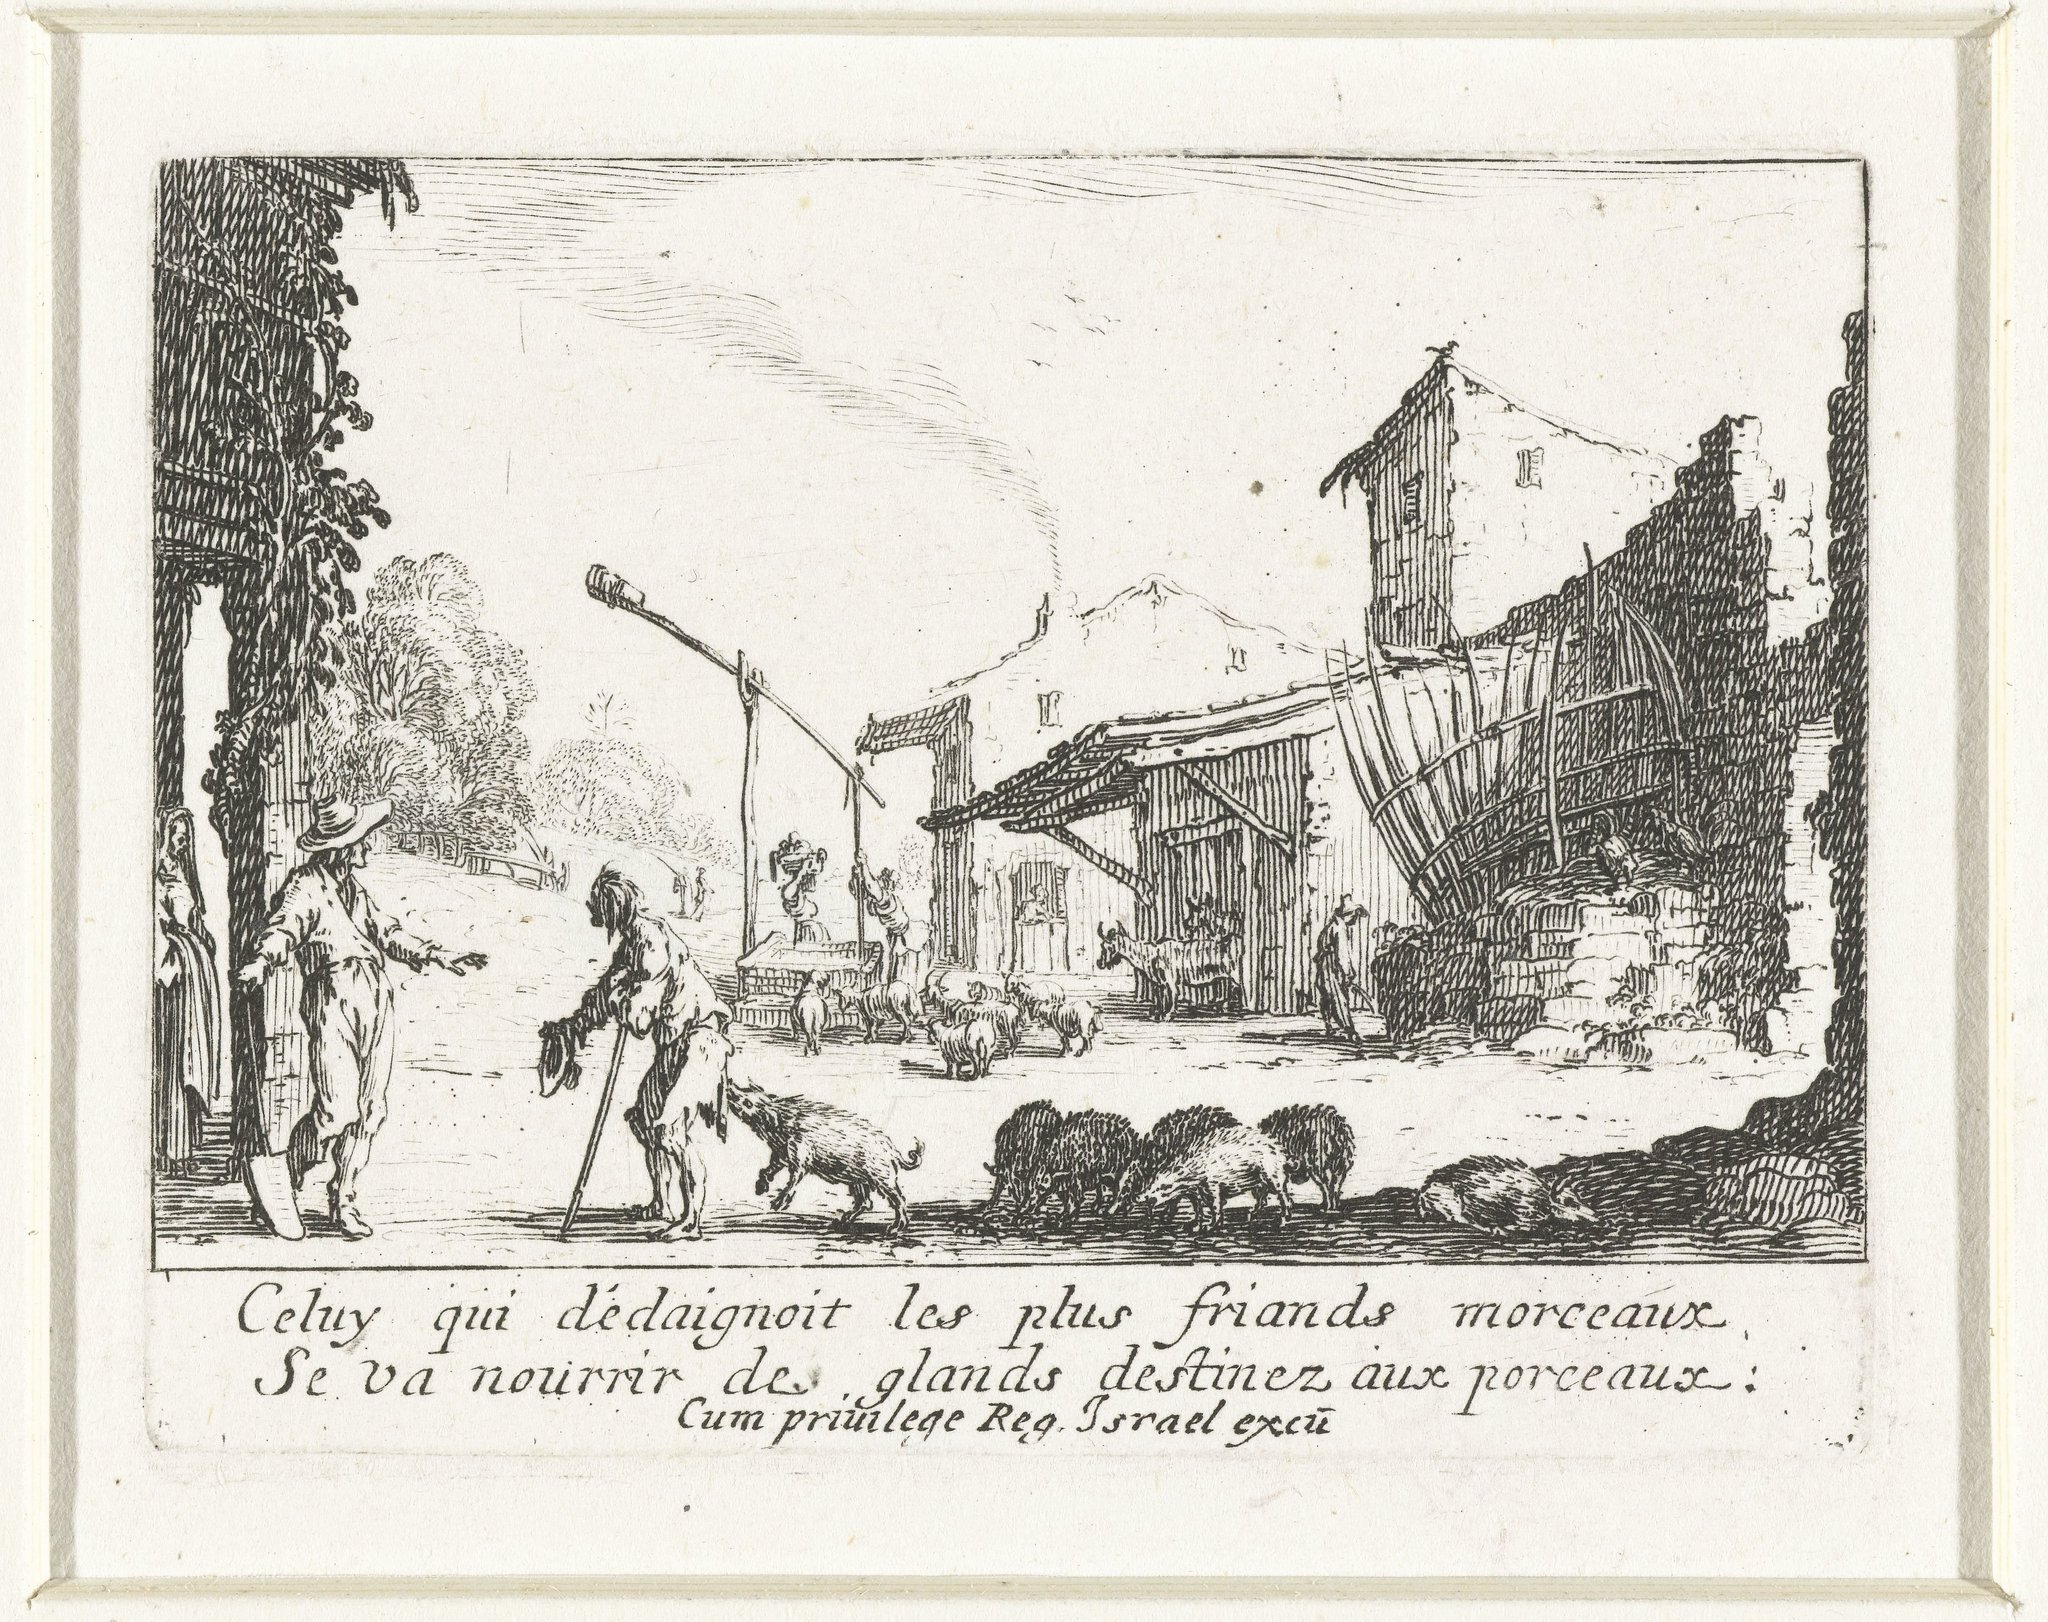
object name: print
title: De verloren zoon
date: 1635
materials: paper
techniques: etching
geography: nancy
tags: the prodigal son, suffering want, asks a farmer for work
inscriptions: collector's mark: Lugt 240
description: In een dorpje vraagt de verloren zoon, totaal berooid, een boer om werk. De zwijnen die hij kan gaan hoeden voor deze man wroeten achter hem in de modder. Onder de voorstelling een tweeregelig Franstalig vers. Deze prent is onderdeel van een reeks prenten rond de gelijkenis van de verloren zoon, bestaande uit een titelprent en tien verhalende voorstellingen.